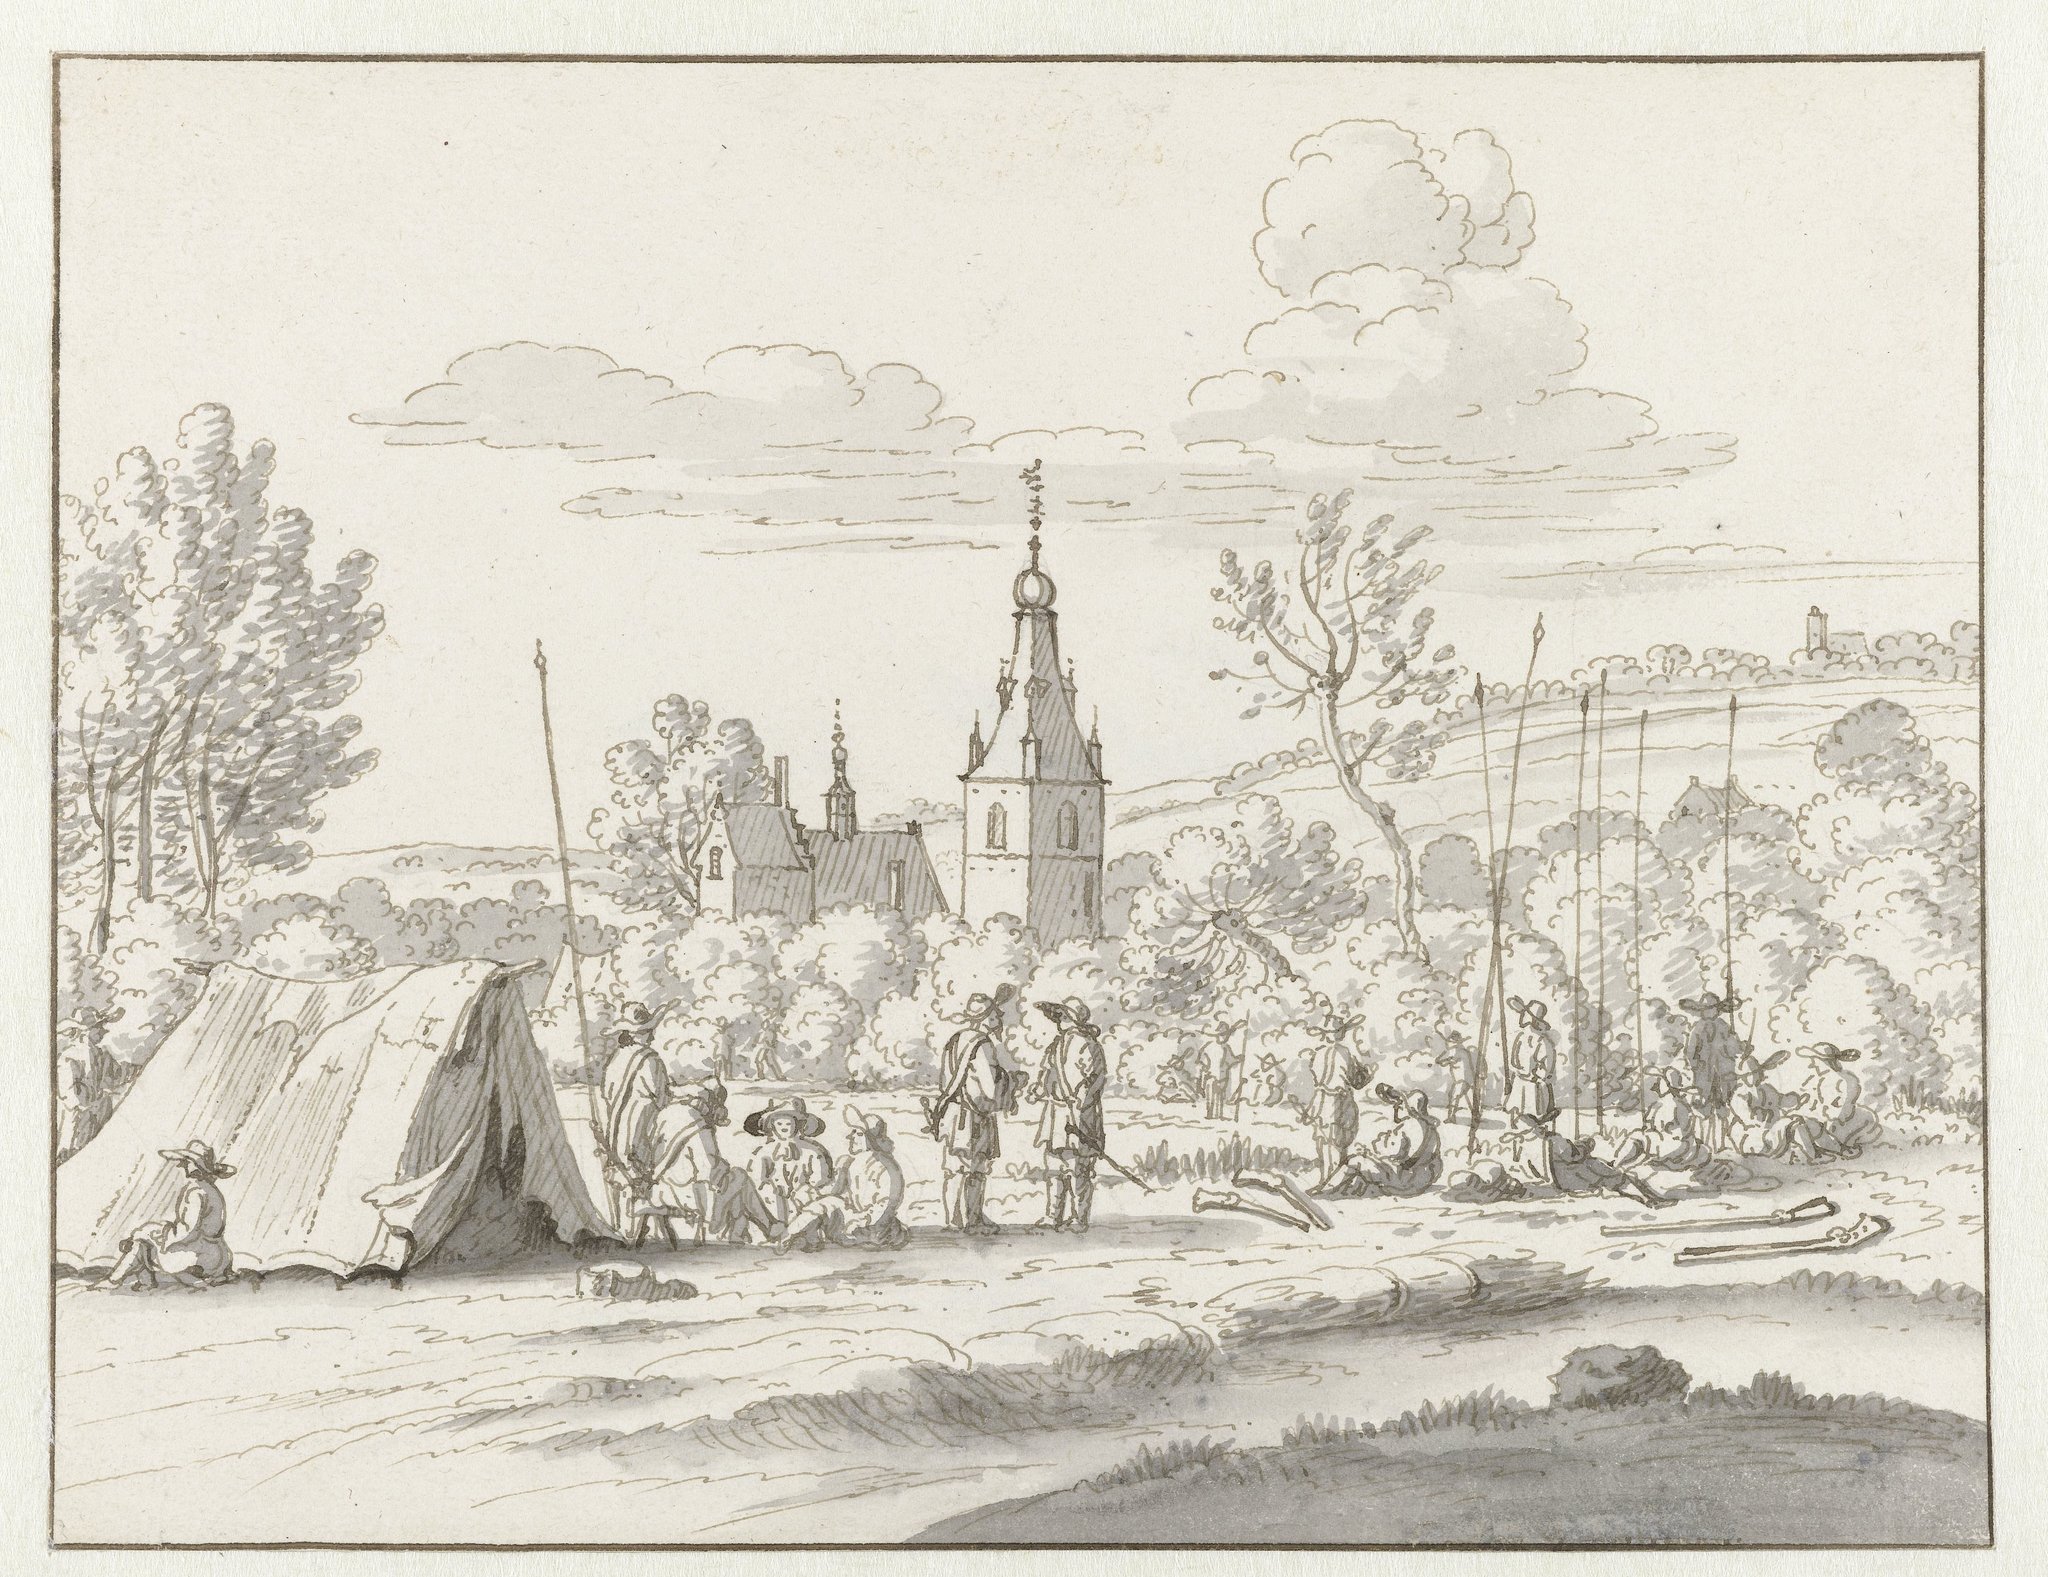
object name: drawing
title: View of an Encampment of the Army of Willem III near Binche, Hainaut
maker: josua de grave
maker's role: draughtsman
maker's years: 1645-1712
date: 1675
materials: ink, paper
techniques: brush, pen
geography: binche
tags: the hague, william iii (prince of orange and king of england, scotland, and ireland), (military) camp with tents, binche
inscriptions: date: ‘16 9/10 75’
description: Kampement van het leger van Willem III bij Binche in Henegouwen, 10 september 1675. Soldaten bij tenten, op de achtergrond de kerktoren.